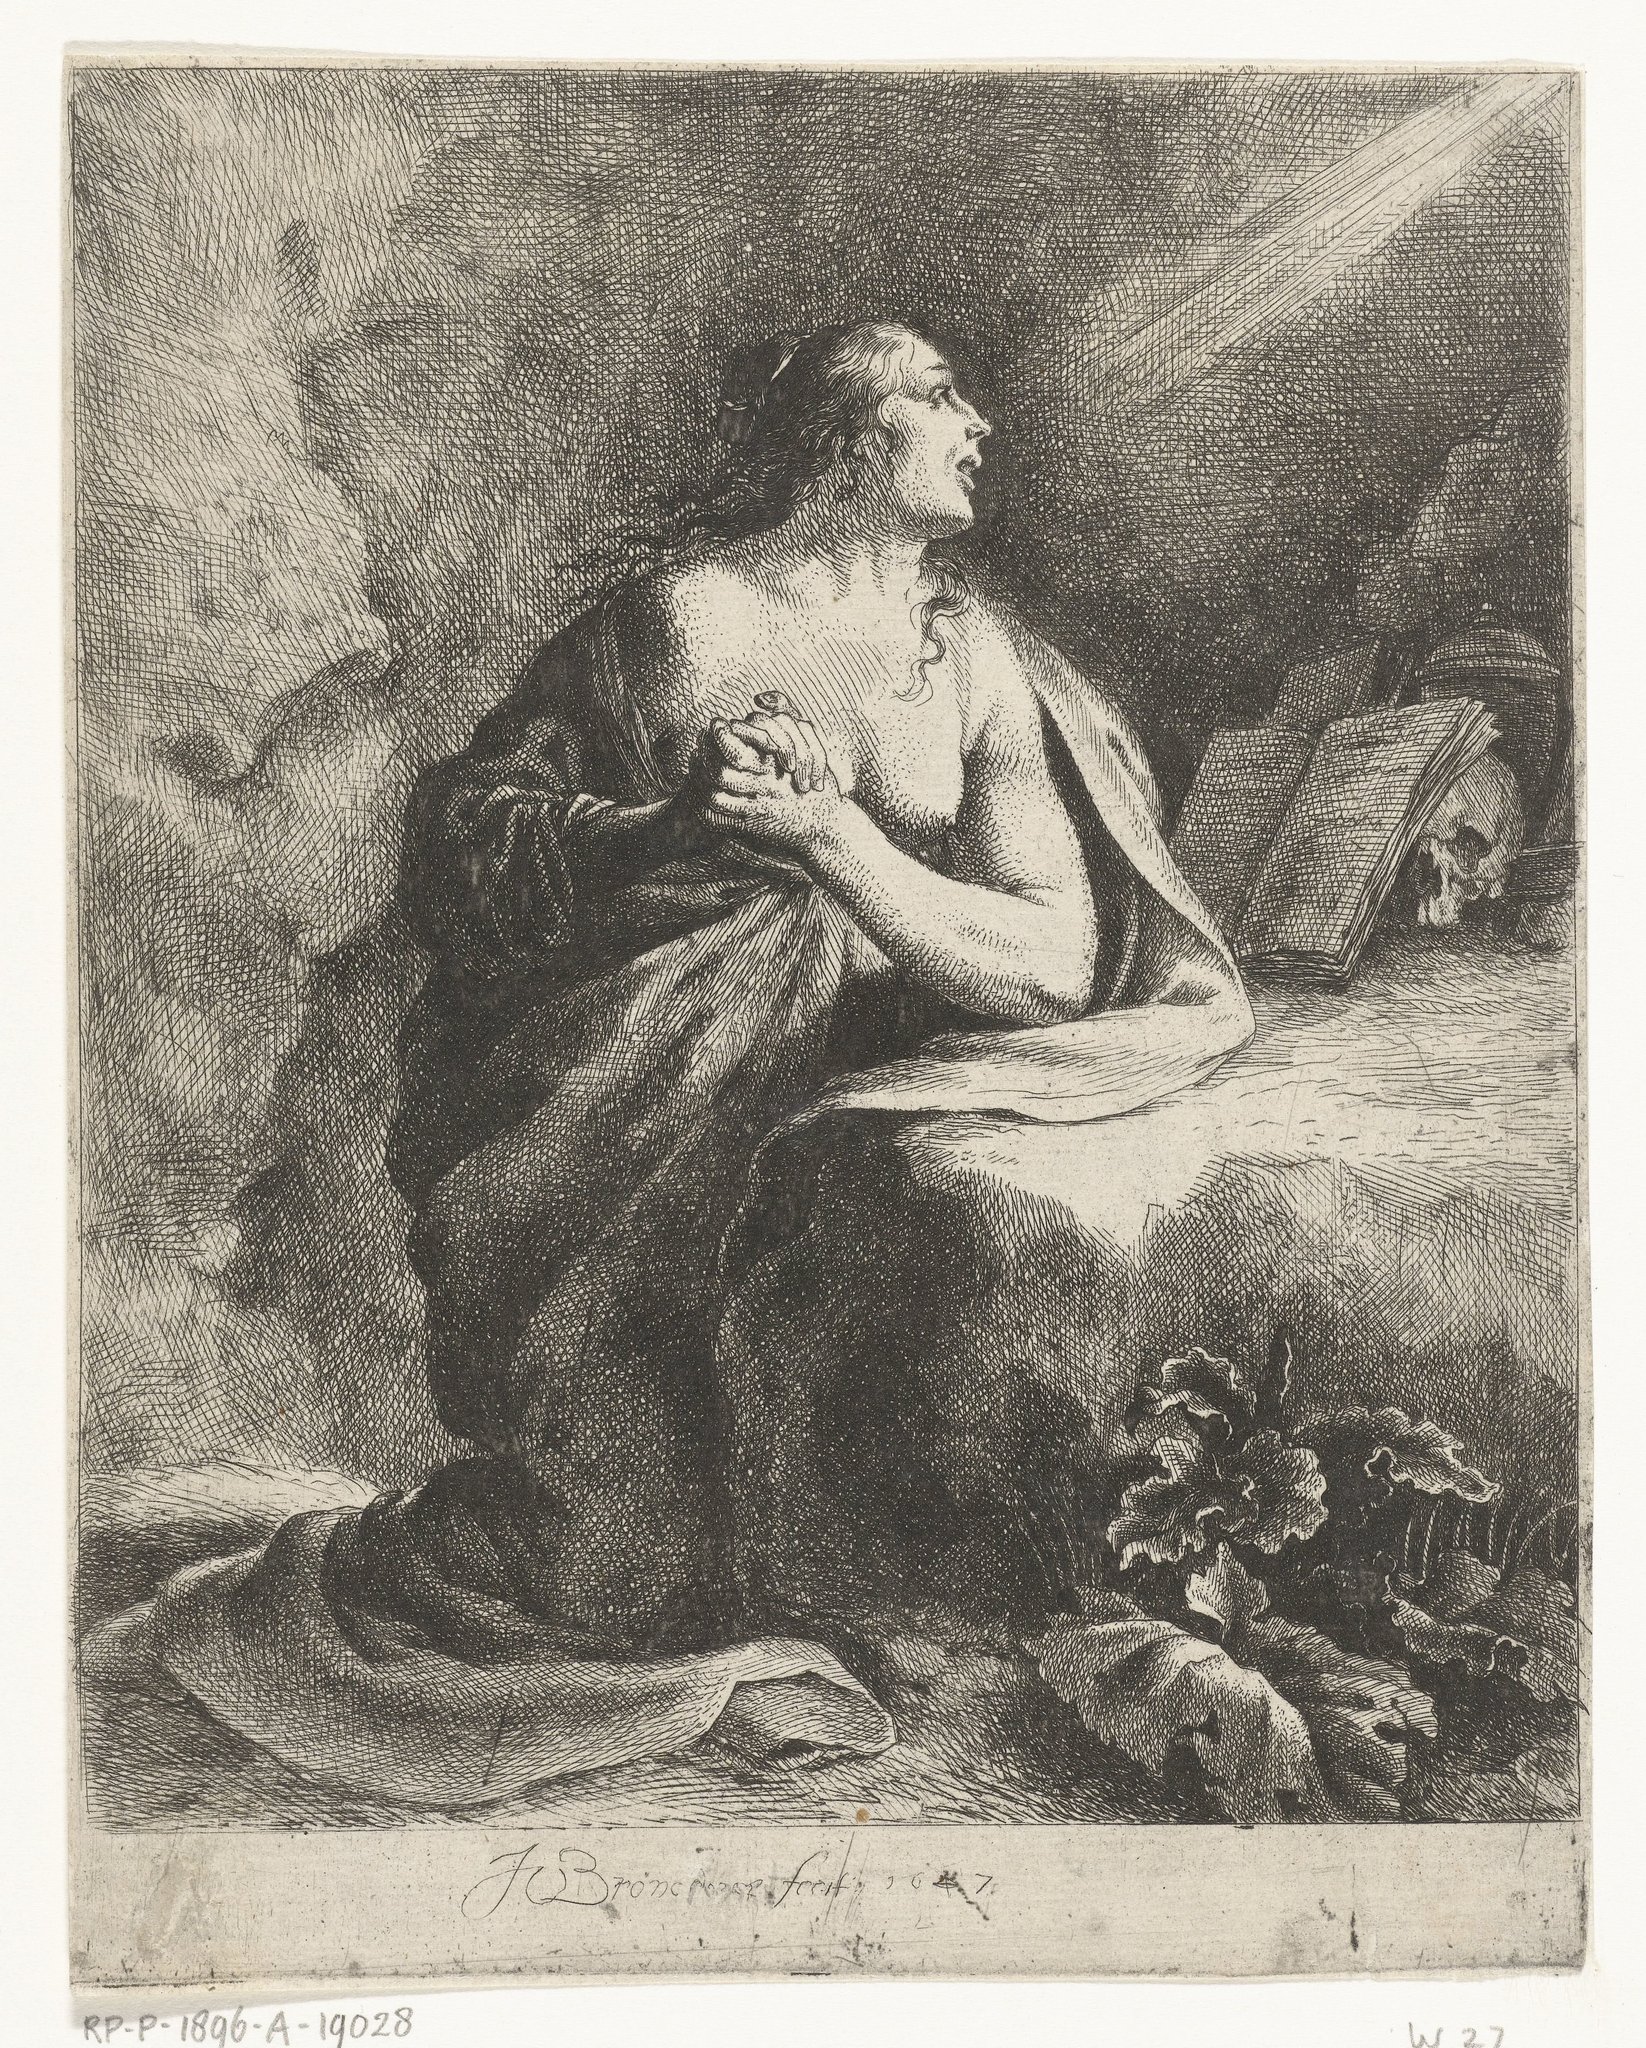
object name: print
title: Boetvaardige Maria Magdalena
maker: jan gerritsz. van bronckhorst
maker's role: draughtsman, painter, print maker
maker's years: 1603-1661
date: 1647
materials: paper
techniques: etching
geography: netherlands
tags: the penitent st. mary magdalene (often before a cave, possibly at la sainte-baume hill): her long hair covers her (naked) body, she reads, meditates or raises her tear-filled eyes towards heaven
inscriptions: collector's mark: Lugt 2228